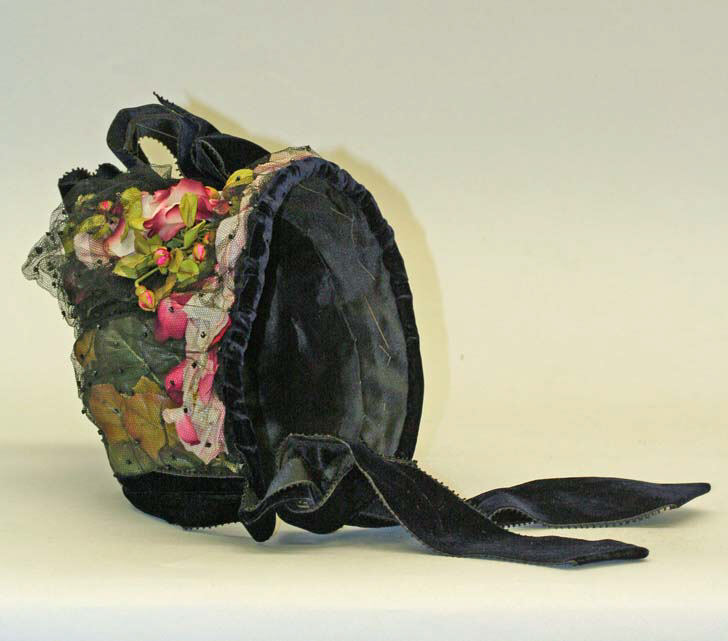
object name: bonnet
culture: american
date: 1880-1889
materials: silk